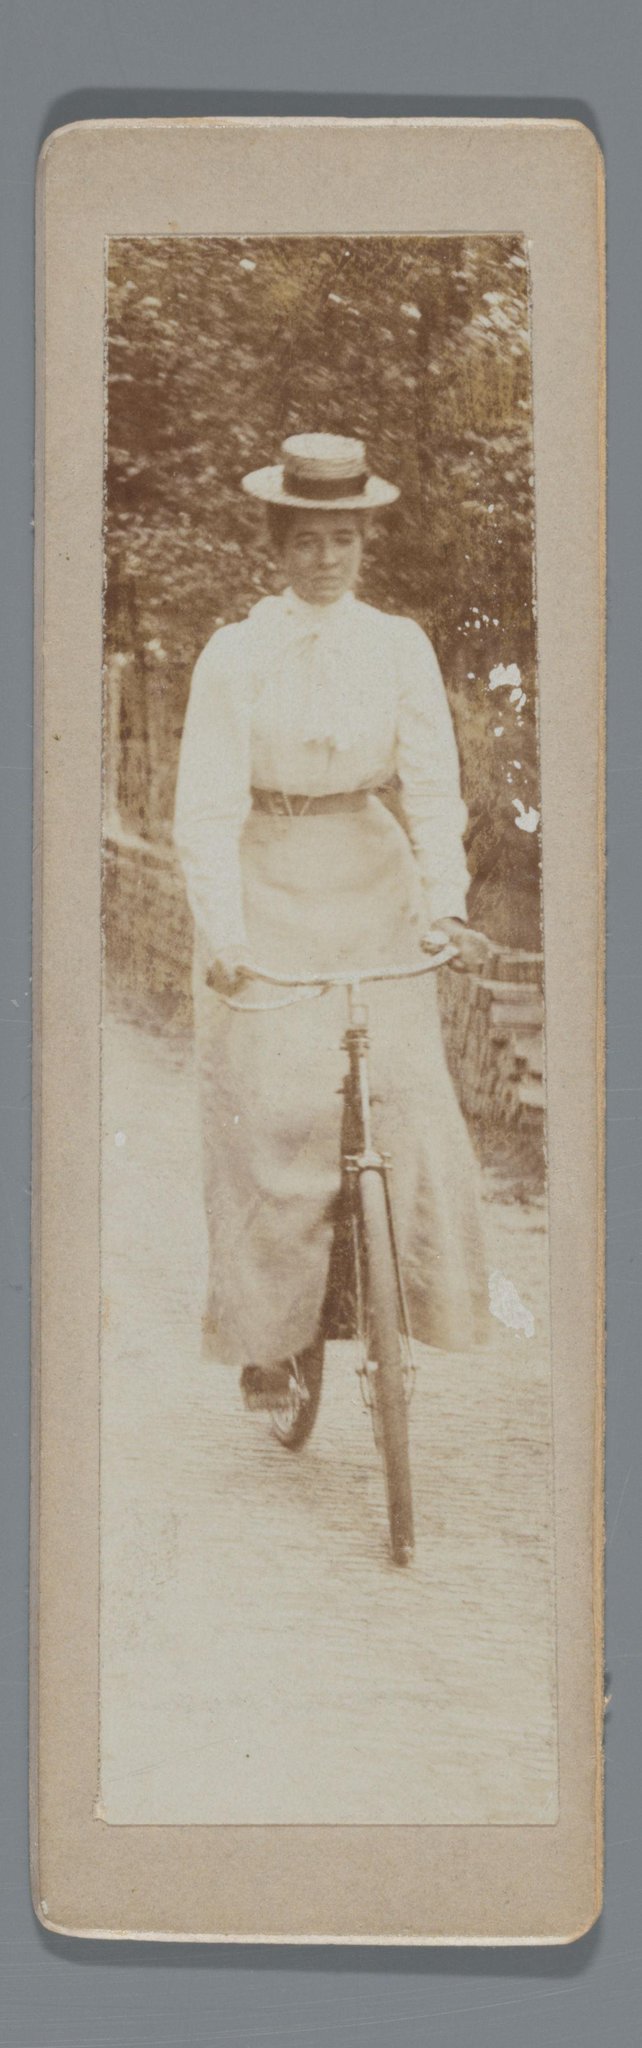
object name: photograph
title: Women Friends on Bicycles during an Outing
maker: Anonymous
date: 1897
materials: paper, cardboard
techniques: collodion silver print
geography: netherlands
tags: historical persons - bb - woman, bicycle (+ one person ~ traffic and transport)